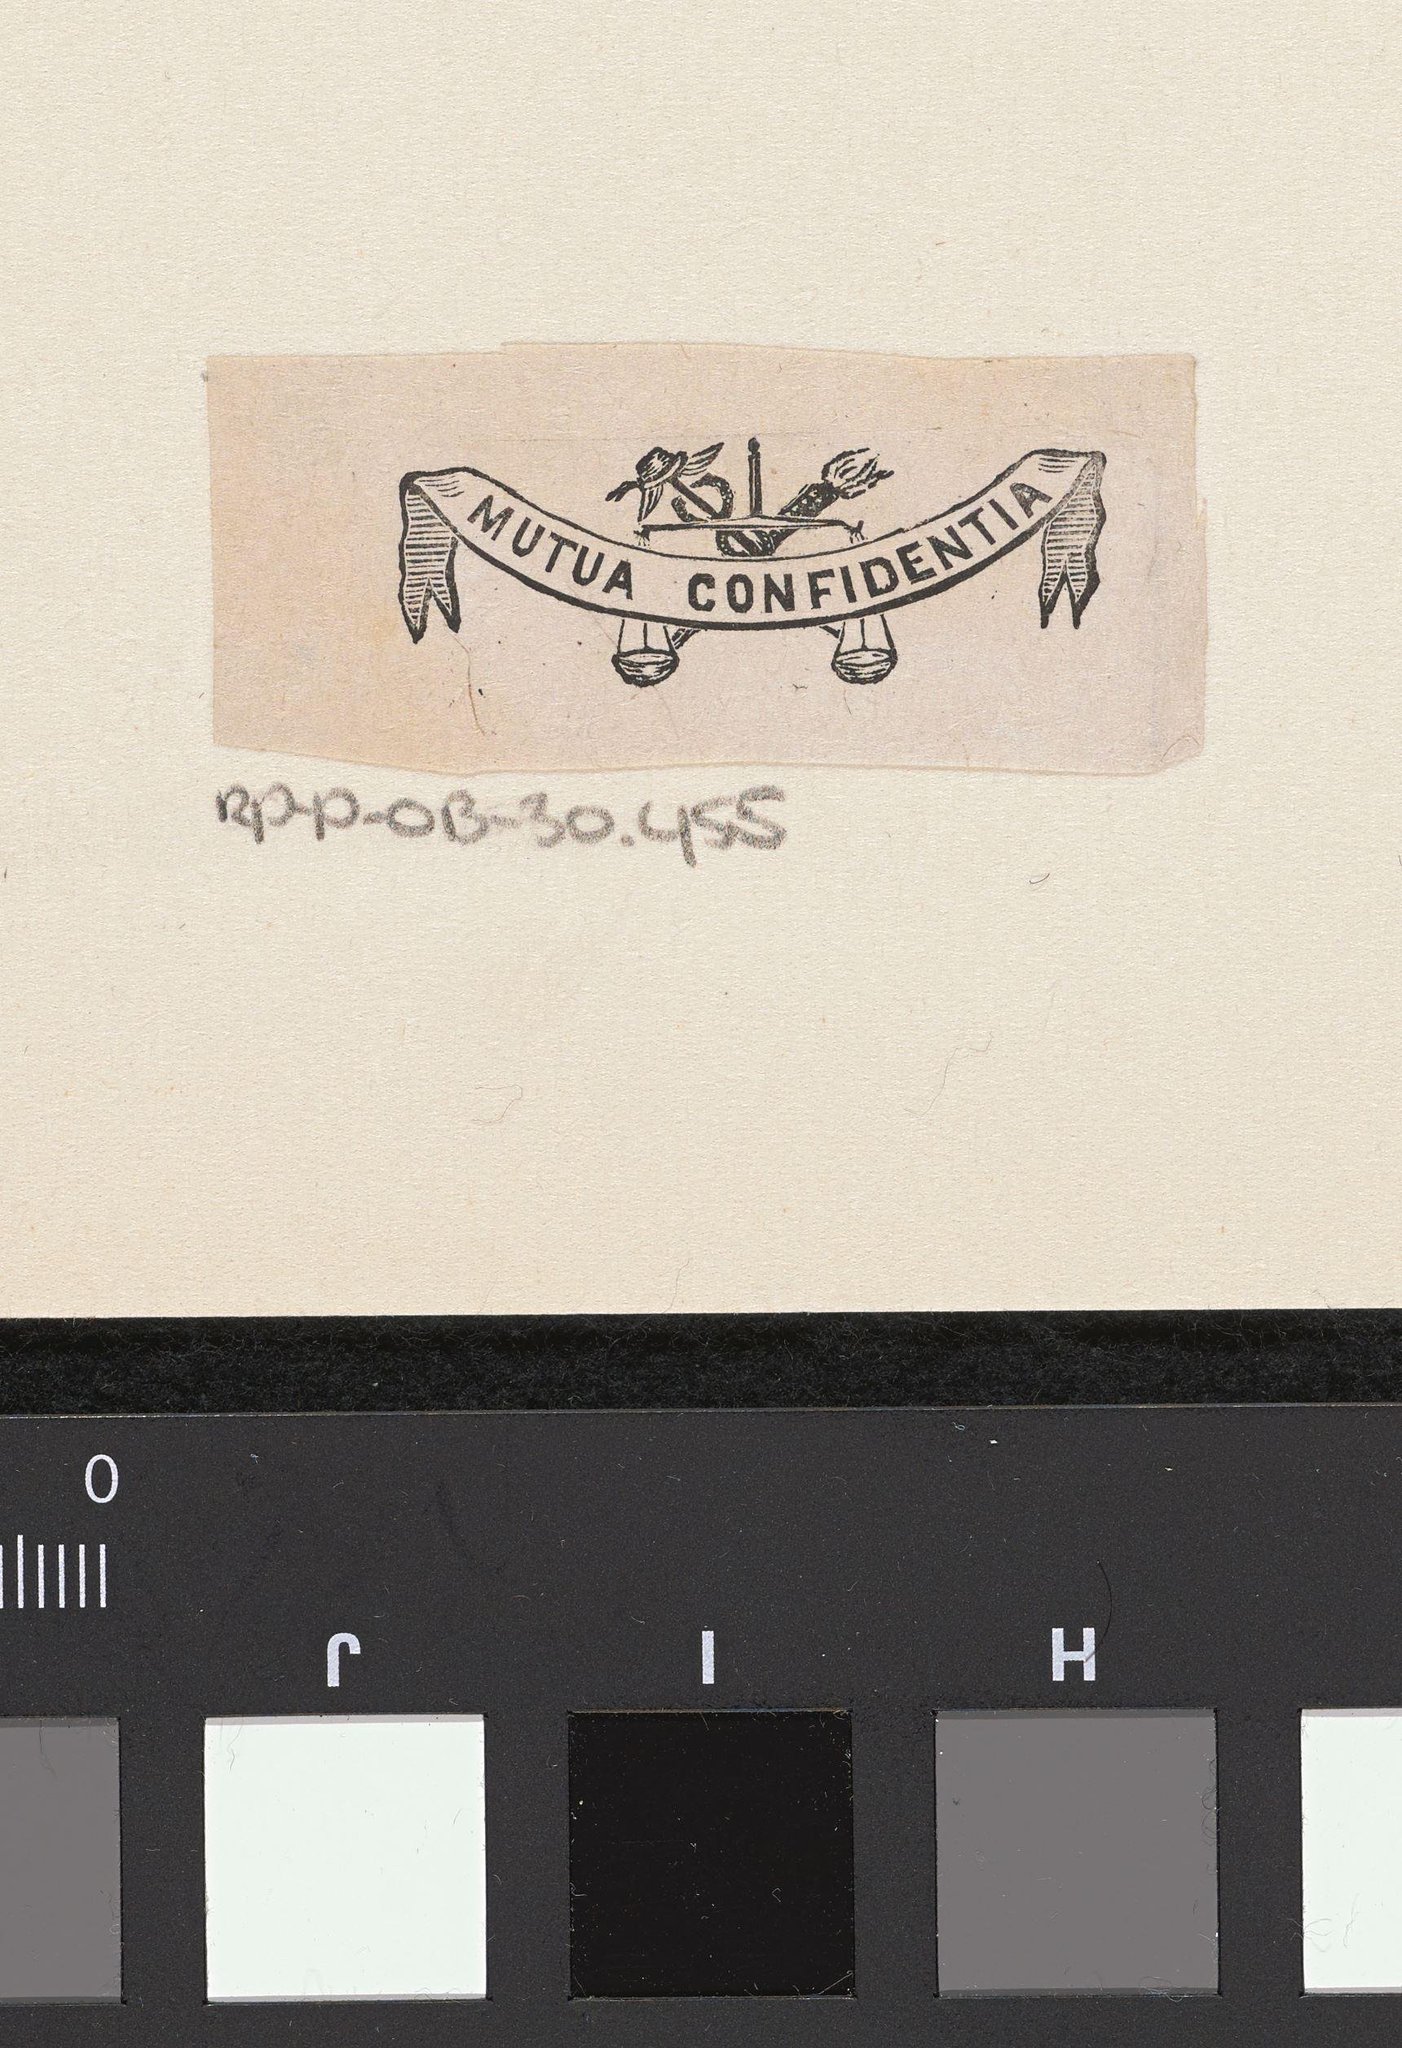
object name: print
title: Vignet met een weegschaal, een Mercuriusstaf en een fakkel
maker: isaac weissenbruch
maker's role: print maker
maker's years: 1826-1912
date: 1836-1912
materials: paper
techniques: engraving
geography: netherlands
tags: torch, scales, caduceus (staff with two snakes, attribute of mercury), vignette